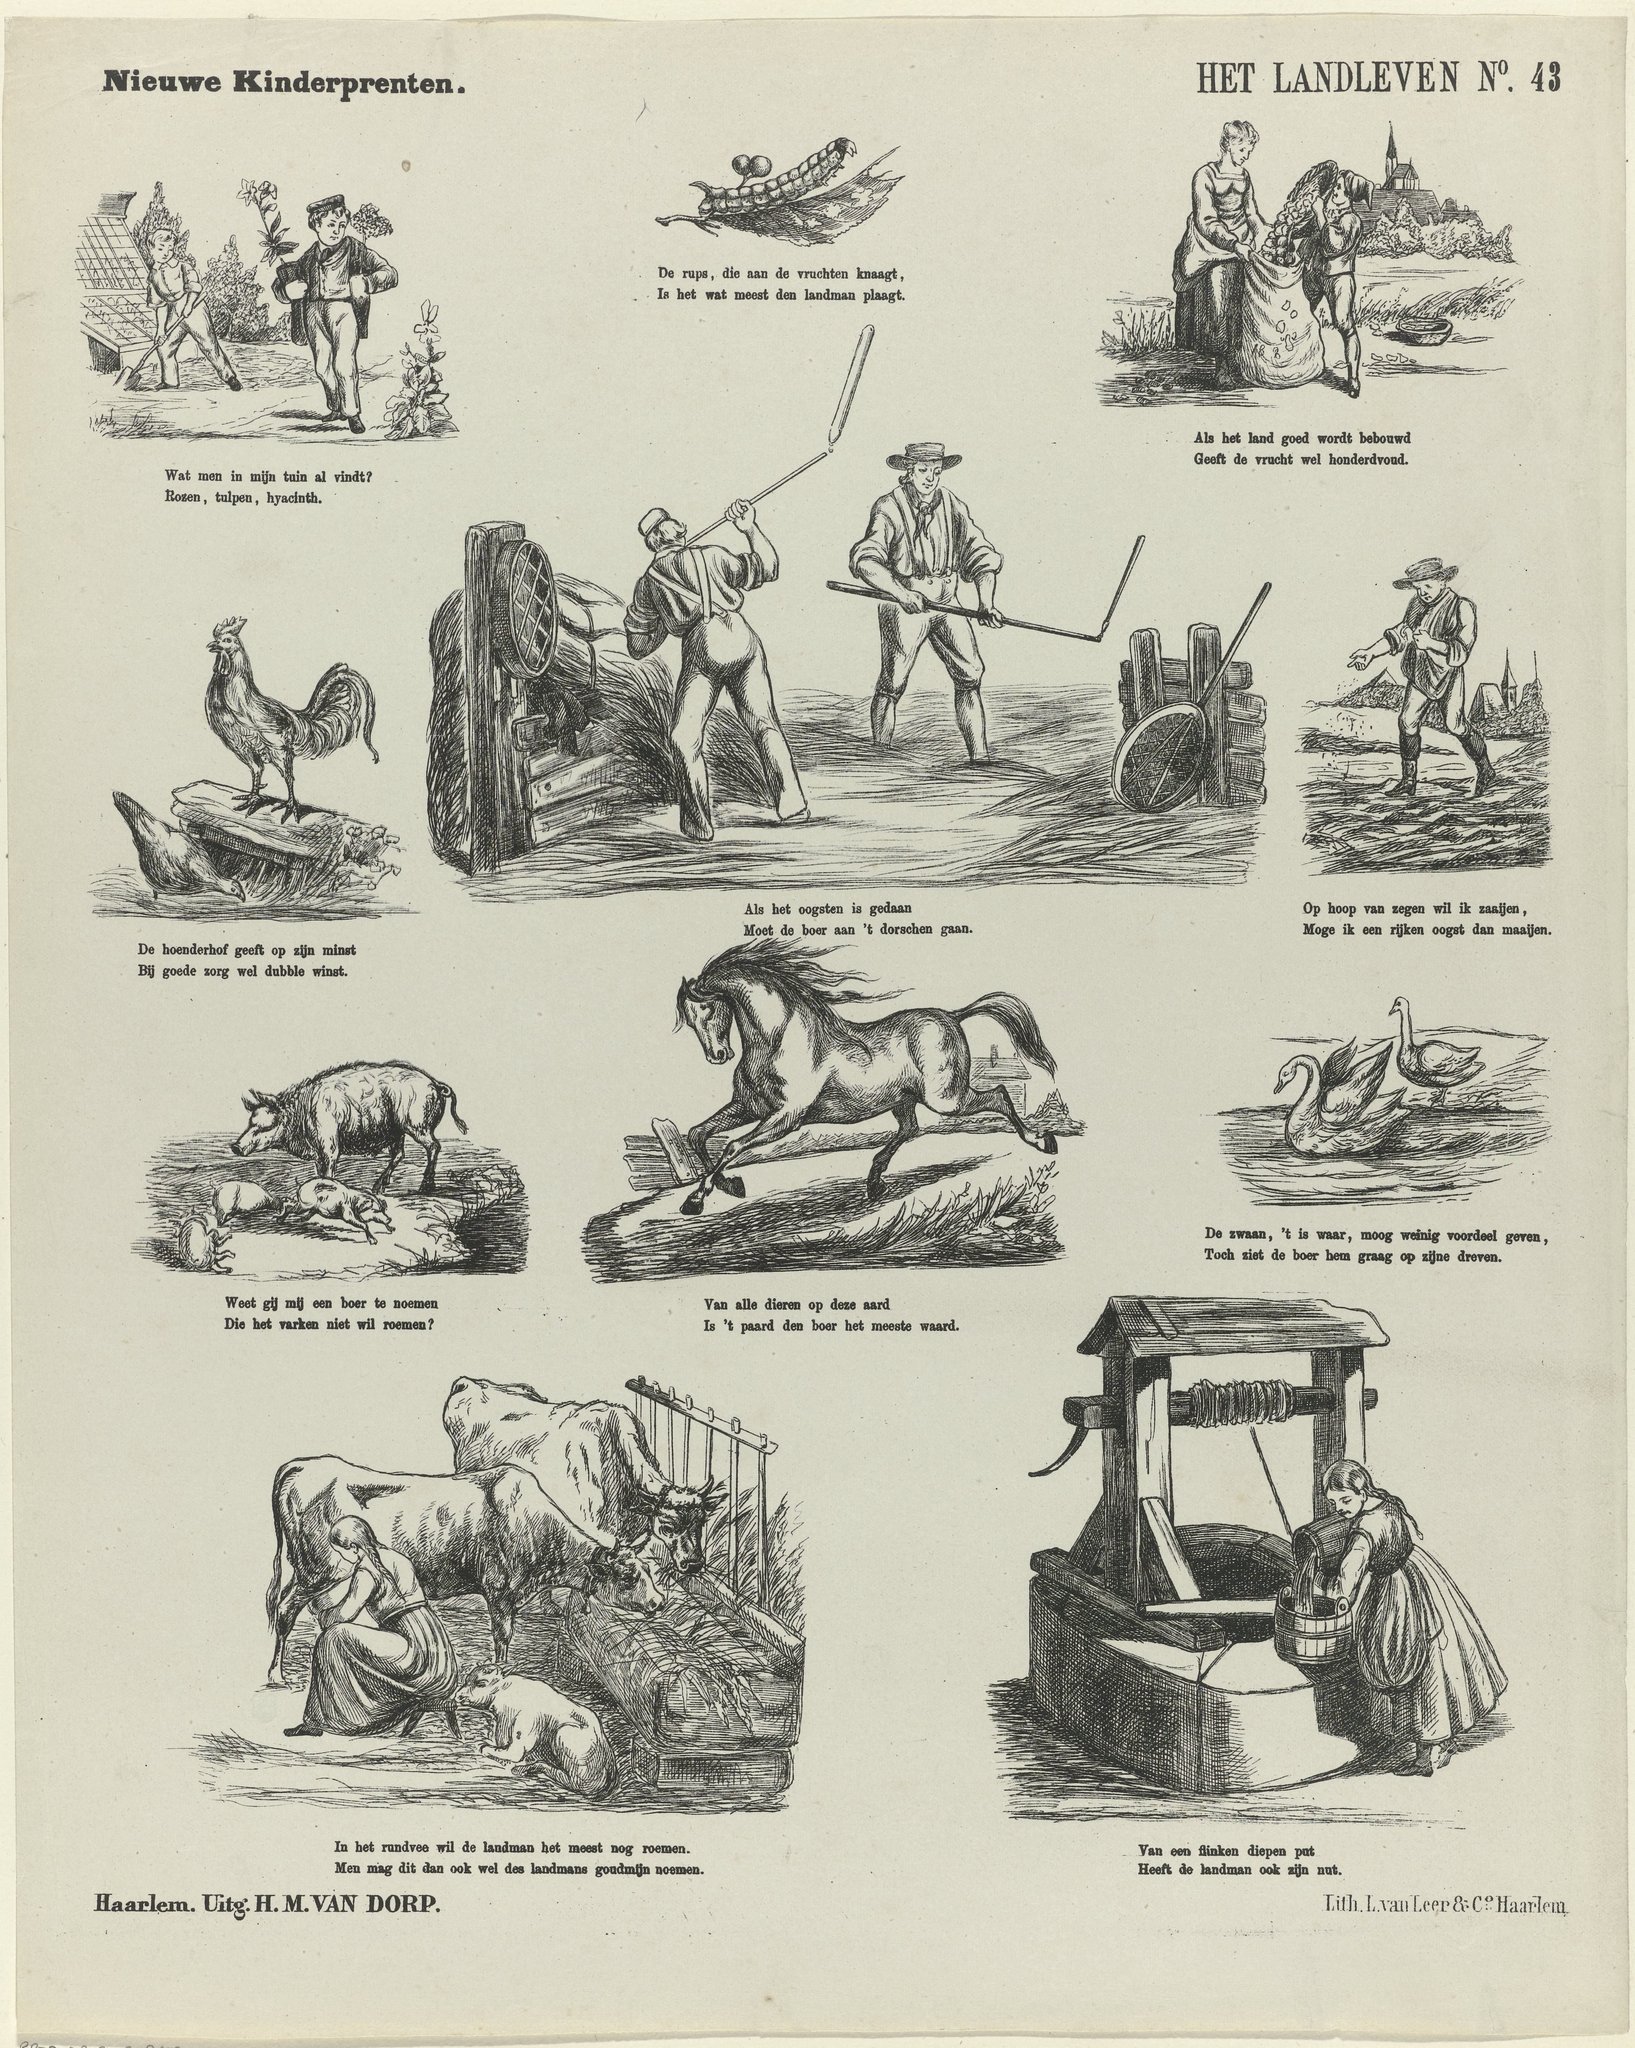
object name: popular print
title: Het landleven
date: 1872-1883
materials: paper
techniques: letterpress printing, lithograph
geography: haarlem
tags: well, animals, farmers, agriculture, milking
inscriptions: collector's mark: Lugt 2760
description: Blad met 11 voorstellingen over het landleven, waaronder boerderijdieren, boeren die dorsen en zaaien en een boerin die water uit de put haalt. Onder elke afbeelding een tweeregelig vers. Genummerd rechtsboven: No. 43.